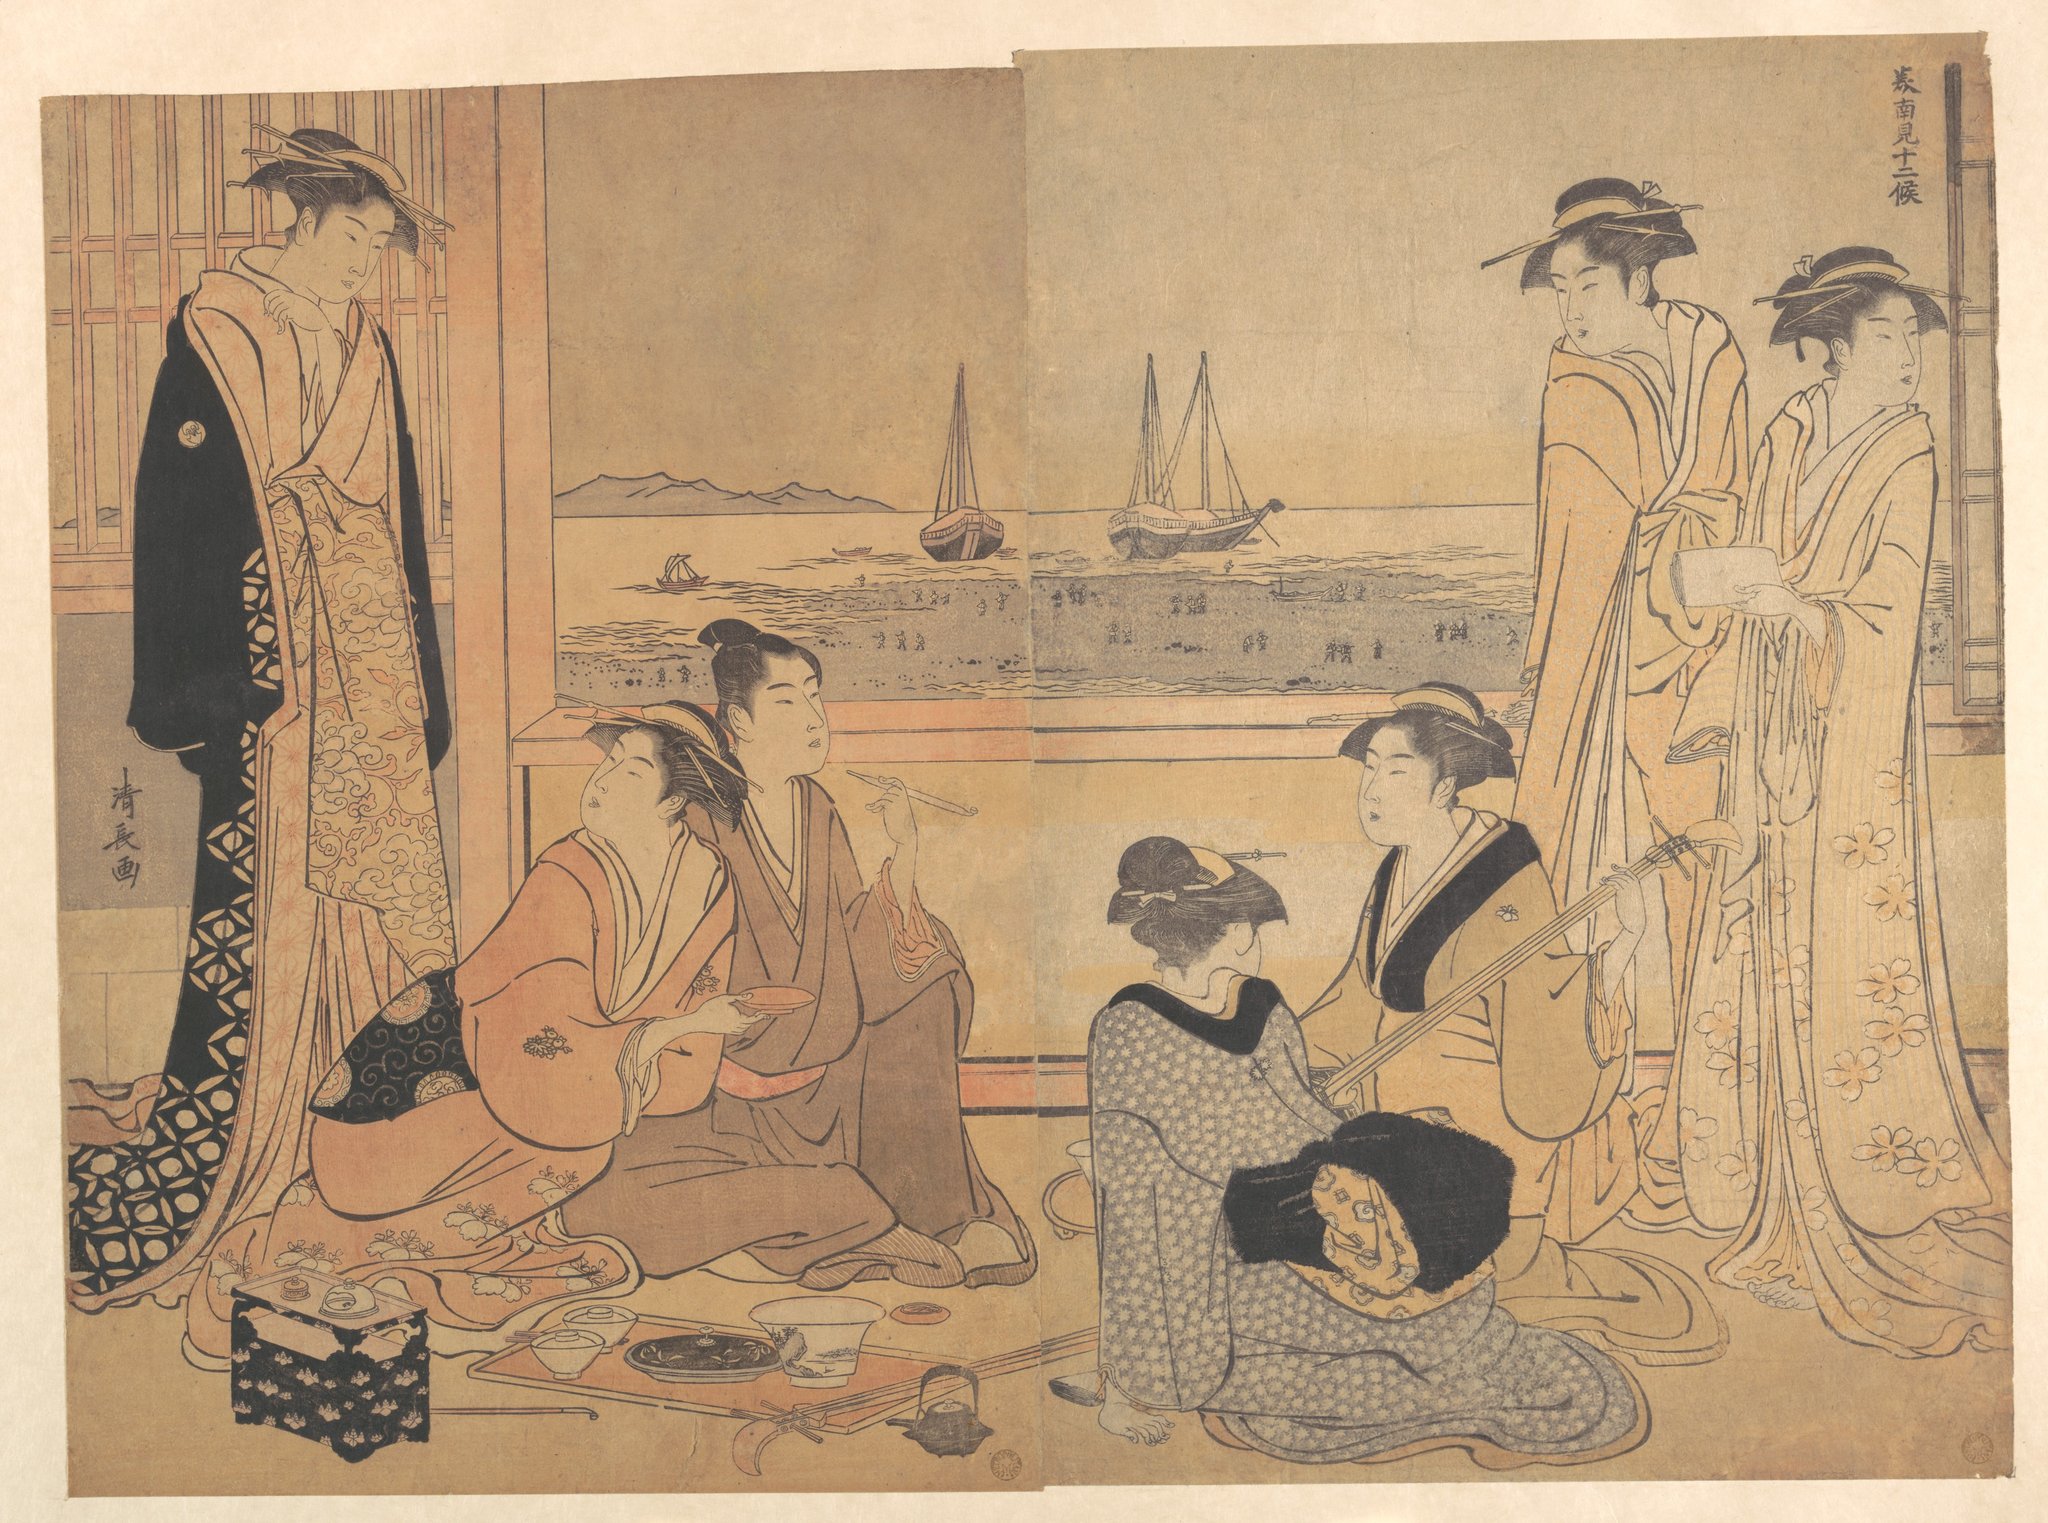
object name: print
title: A Party of Merrymakers in a Tea-house at Shinagawa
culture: japanese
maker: torii kiyonaga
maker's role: artist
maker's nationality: japanese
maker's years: 1752-1815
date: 1783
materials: ink, paper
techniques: woodblock print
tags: women,musicians,boats,eating,tea houses